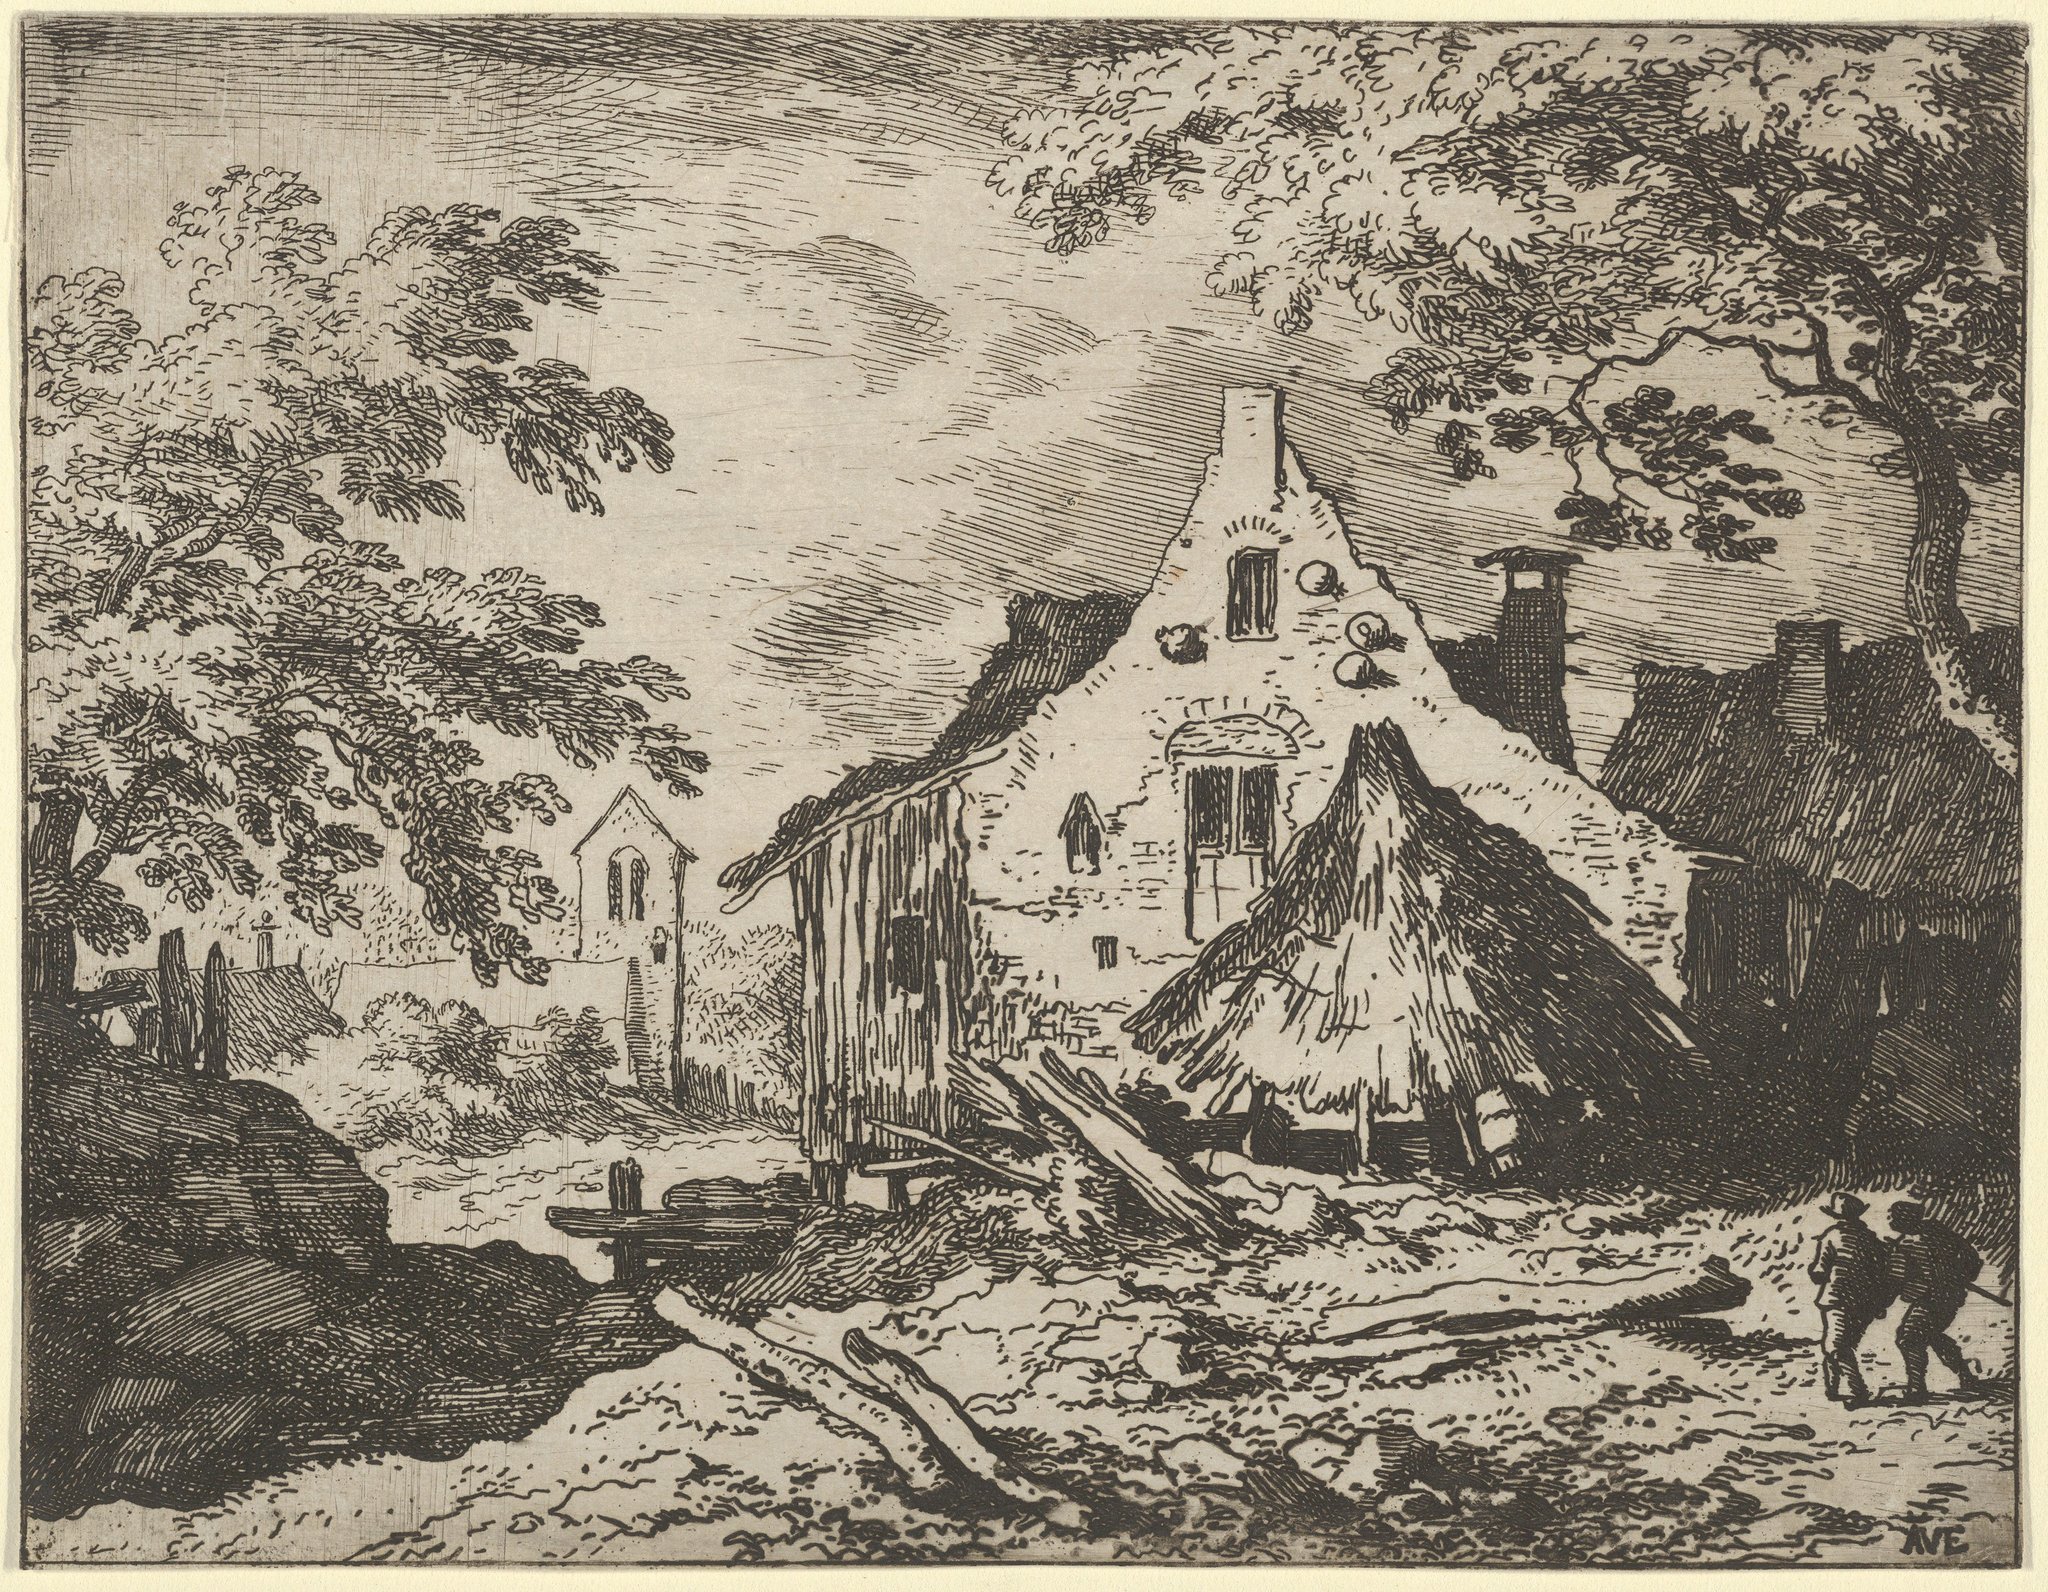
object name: print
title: The Haybarn with Movable Roof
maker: allart van everdingen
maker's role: artist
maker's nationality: dutch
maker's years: 1621-1675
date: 1621-1675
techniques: engraving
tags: barns